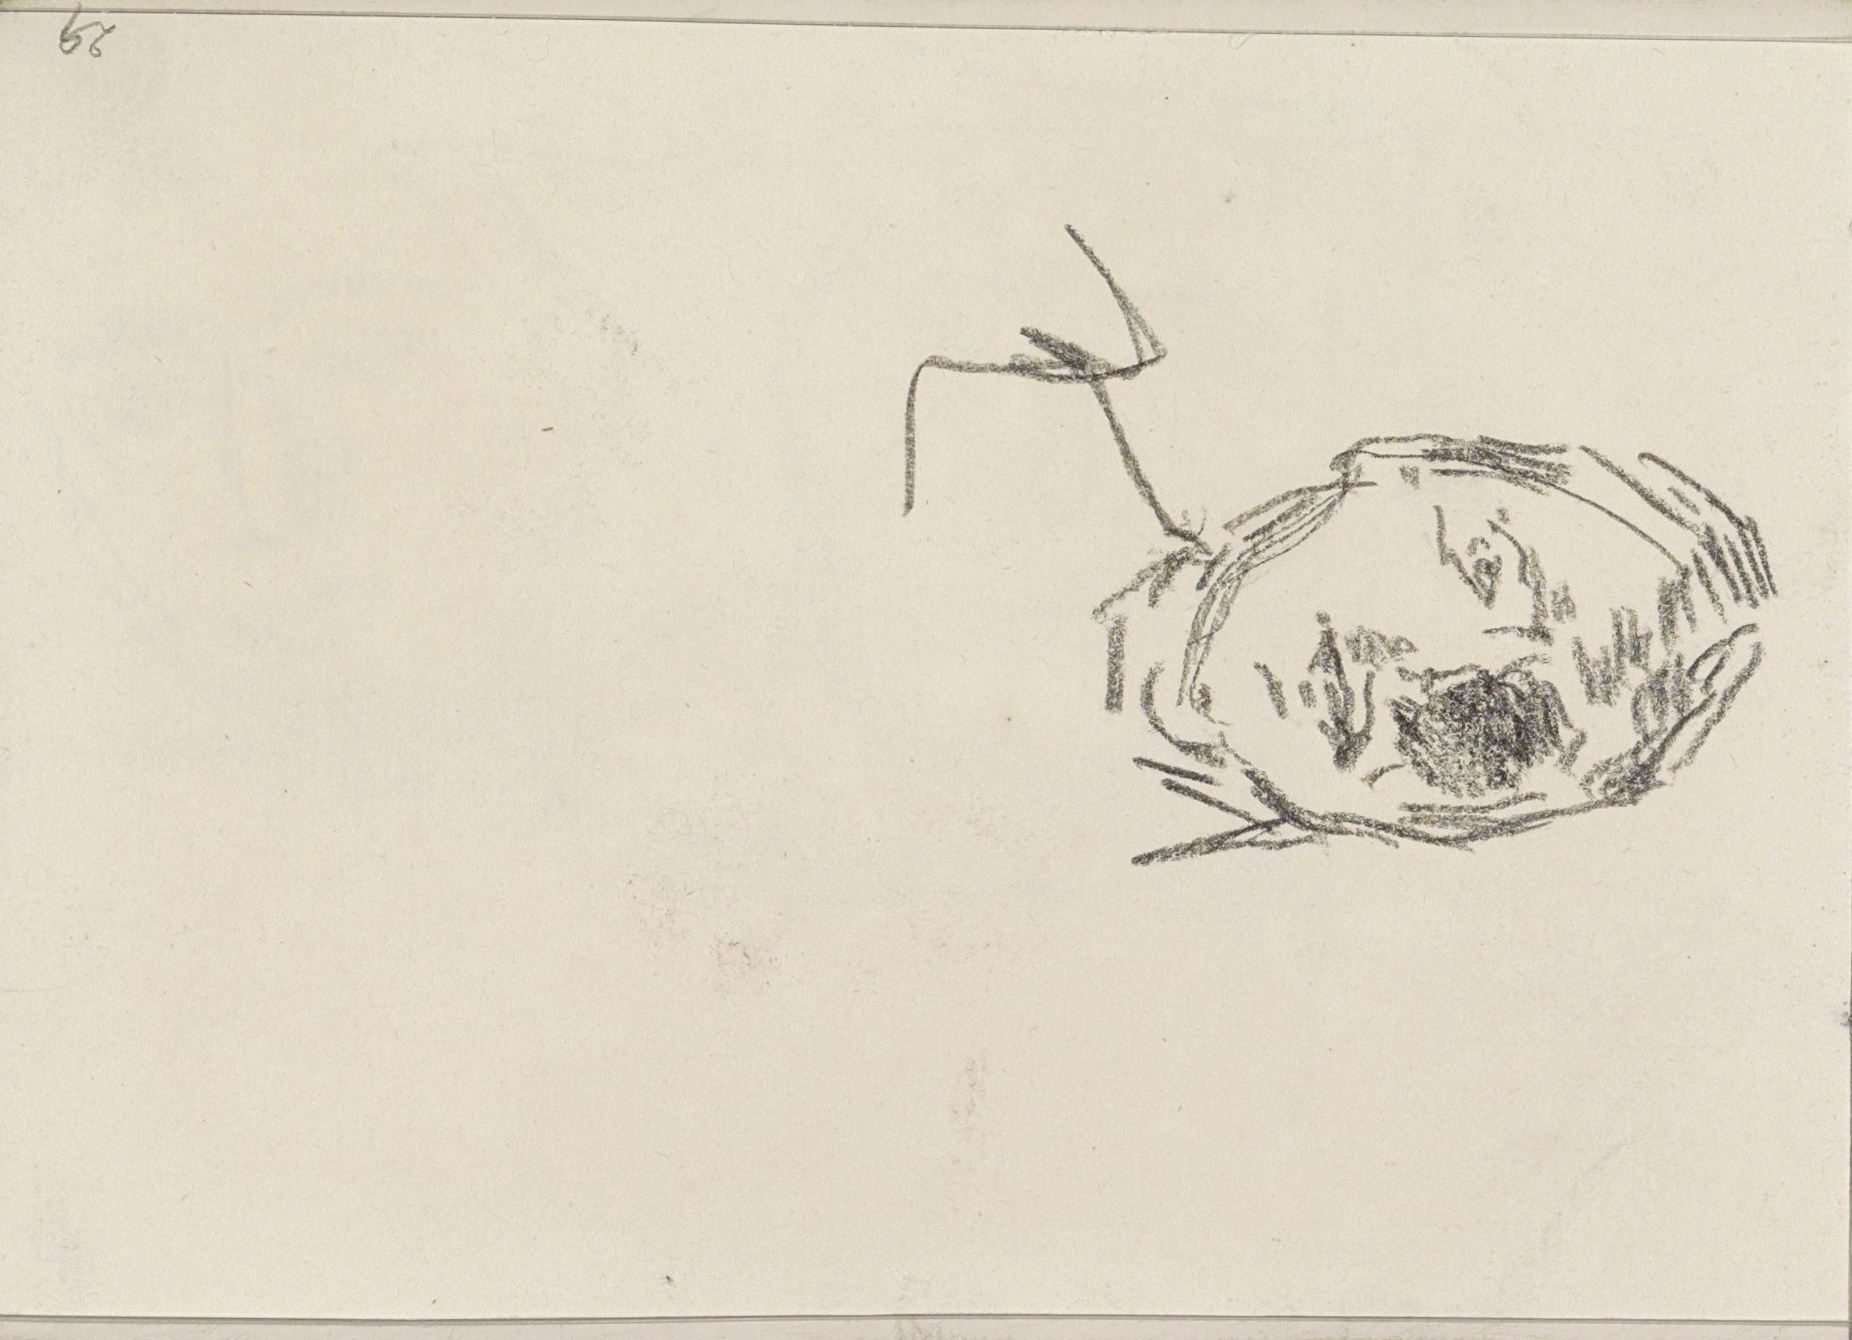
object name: sketchbook leaf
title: Vrouwenhoofd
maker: isaac israels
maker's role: draughtsman, painter, print maker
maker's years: 1865-1934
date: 1875-1934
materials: chalk, paper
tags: head (human) - aa - female human figure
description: Blad 24 verso uit schetsboek LVI met 26 bladen.